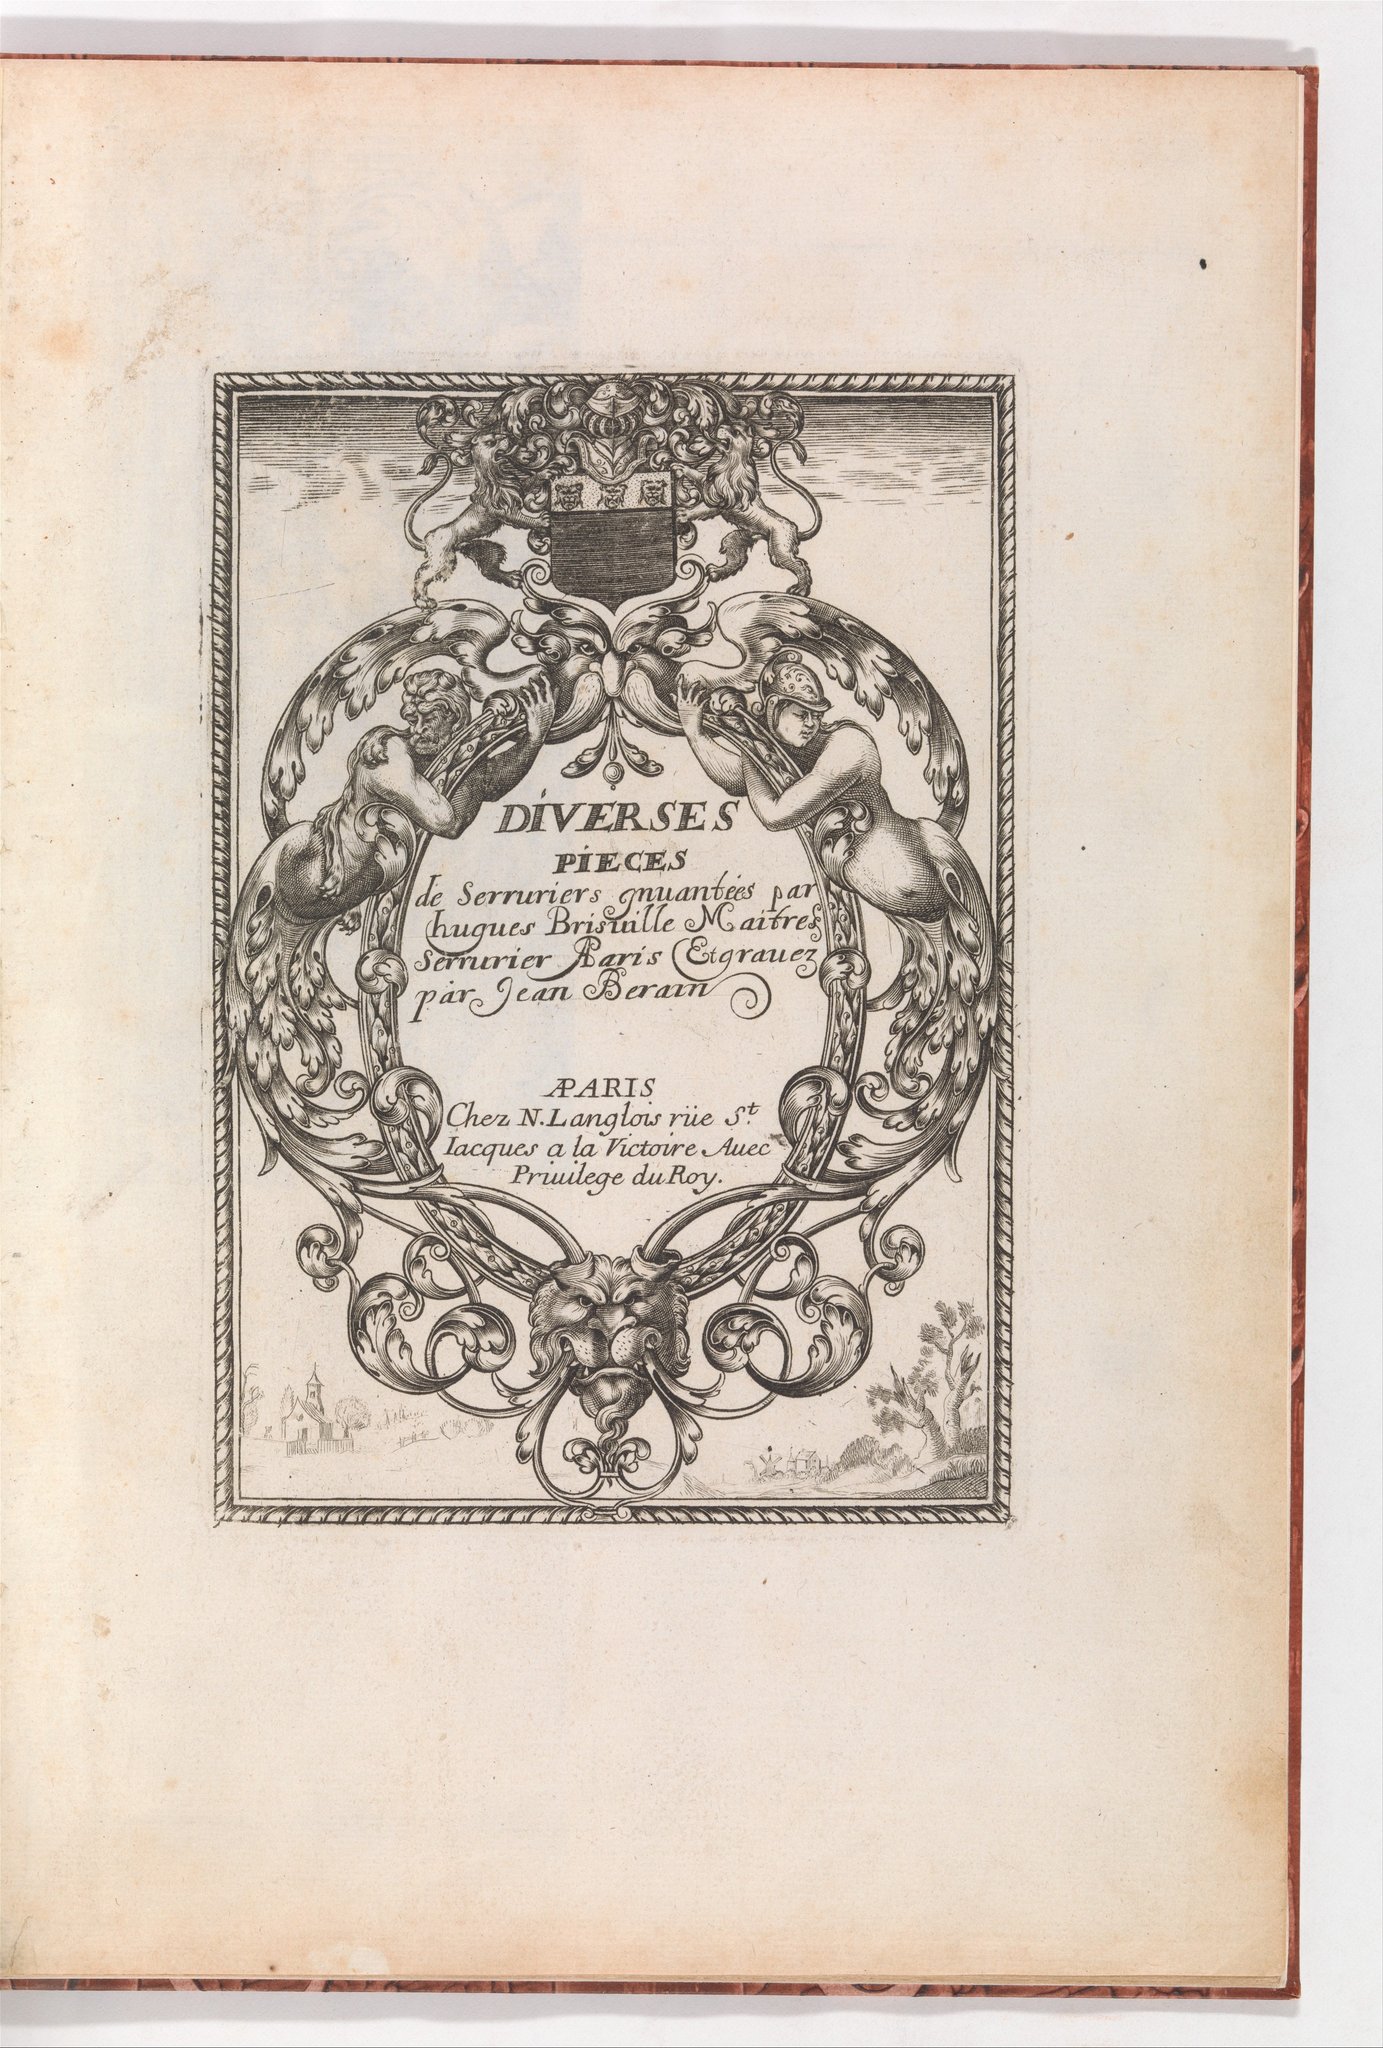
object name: album print ornament architecture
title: Diverses Pieces de Serruriers, title page (recto)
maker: jean berain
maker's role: artist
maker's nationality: french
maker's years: 1640-1711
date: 1663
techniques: engraving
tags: grotesques,ornament,lions,vines,coat of arms